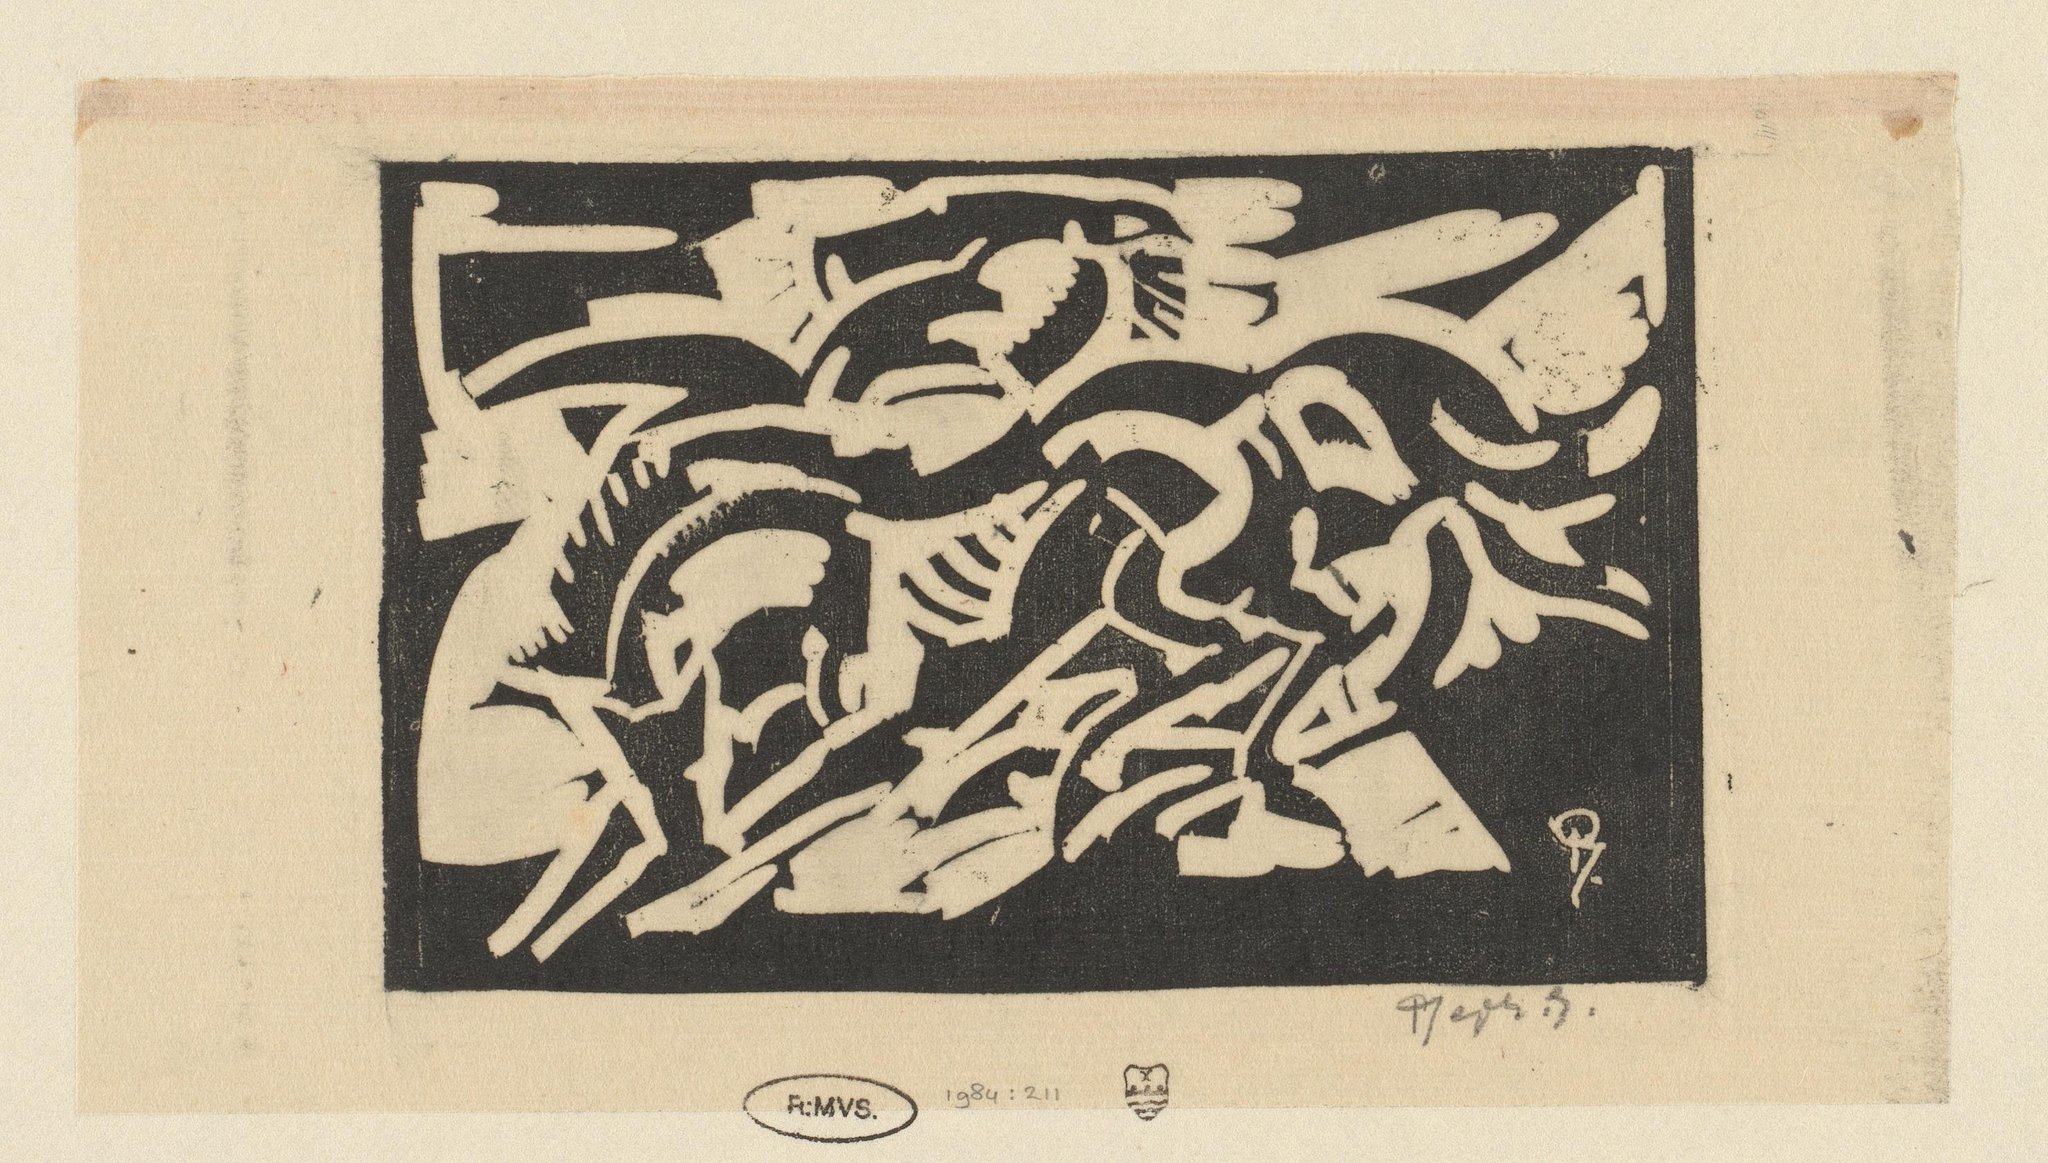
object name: print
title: Steigerend en bokkend paard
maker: reijer stolk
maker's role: draughtsman, print maker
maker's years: 1896-1945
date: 1921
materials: paper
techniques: woodcut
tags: rearing (horse in motion), horse, kicking (horse in motion)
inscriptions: collector's mark: Lugt 2760, collector's mark: Lugt 2228